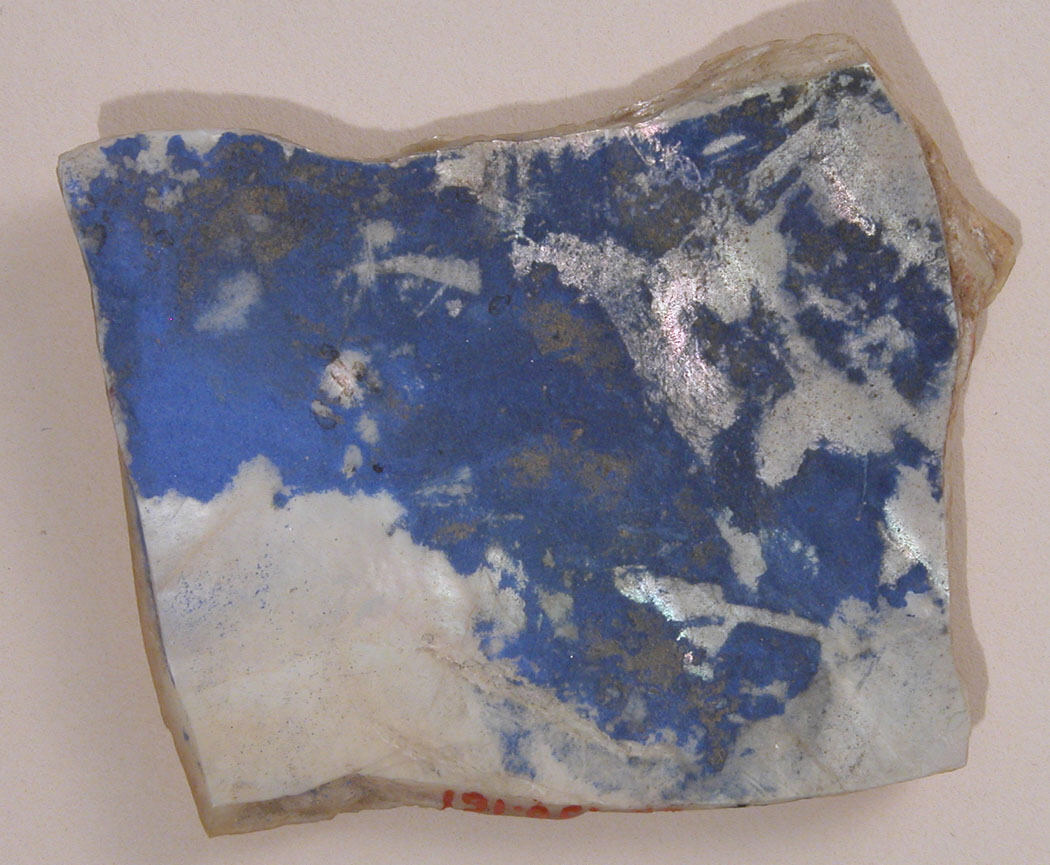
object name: fragment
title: Shell with traces of blue paint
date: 601-1000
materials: lapis lazuli, pigment, shell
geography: iraq